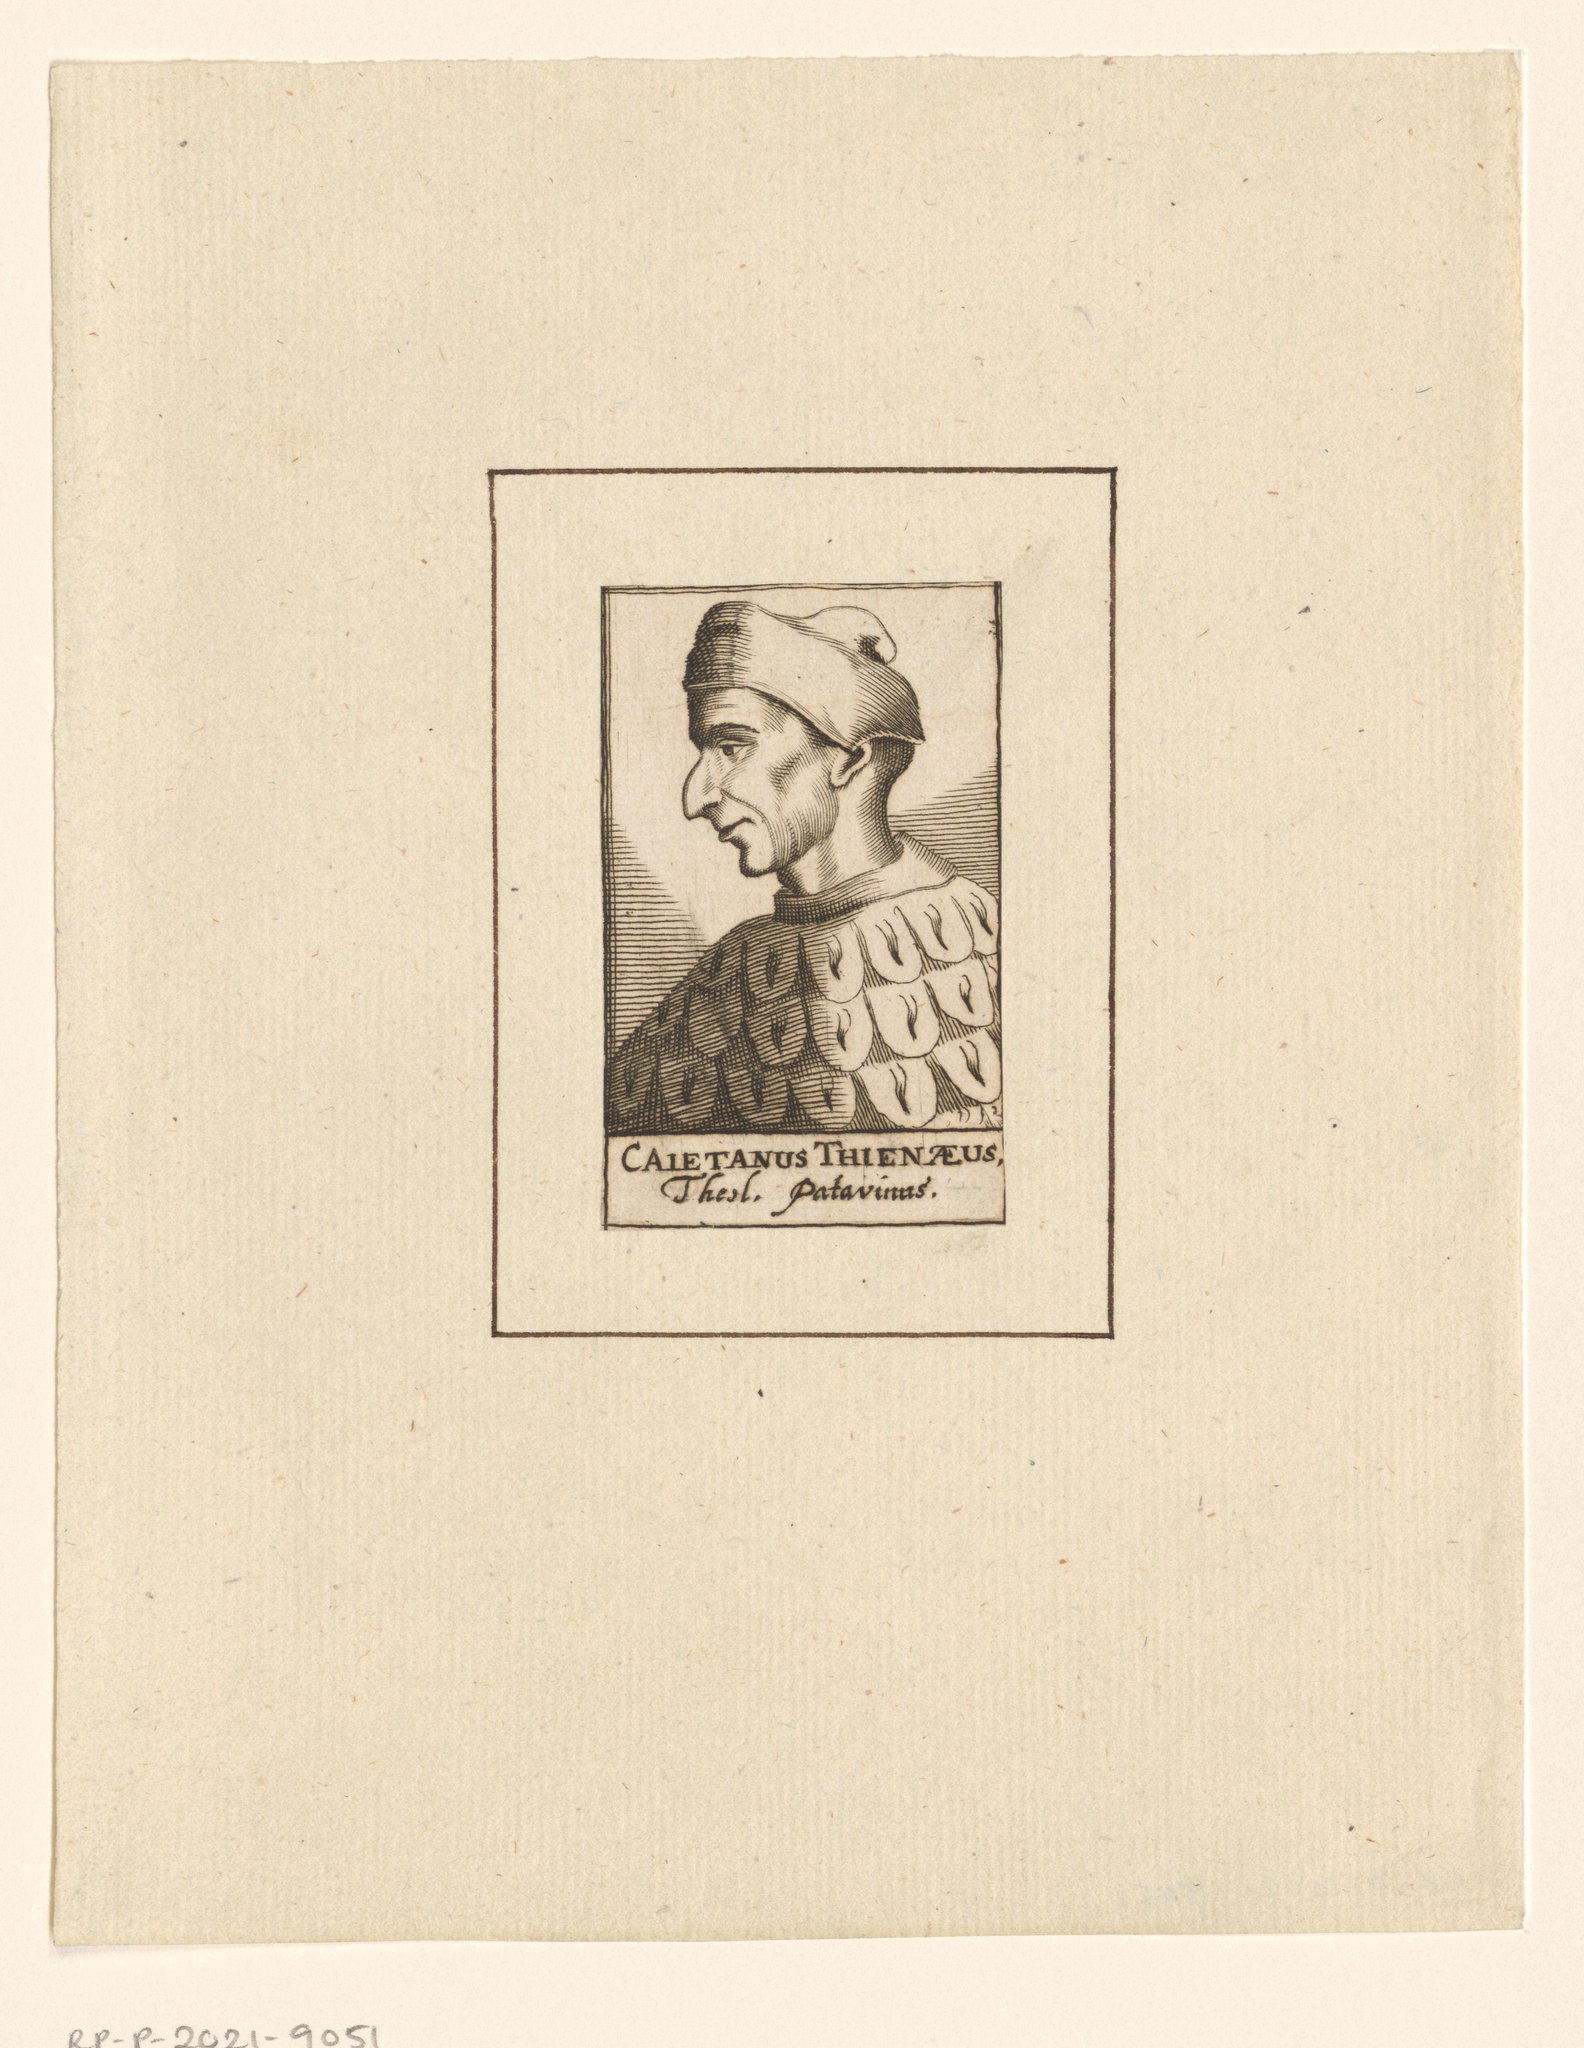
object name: book illustration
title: Portret van Cajetanus van Thiene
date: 1688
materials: paper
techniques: engraving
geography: nuremberg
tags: naples, ethics; 'etica' (ripa), historical persons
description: Prent uit: Freher, Paul. Theatrum virorum eruditione clarorum. Neurenberg: Johann Hoffmann, 1688.